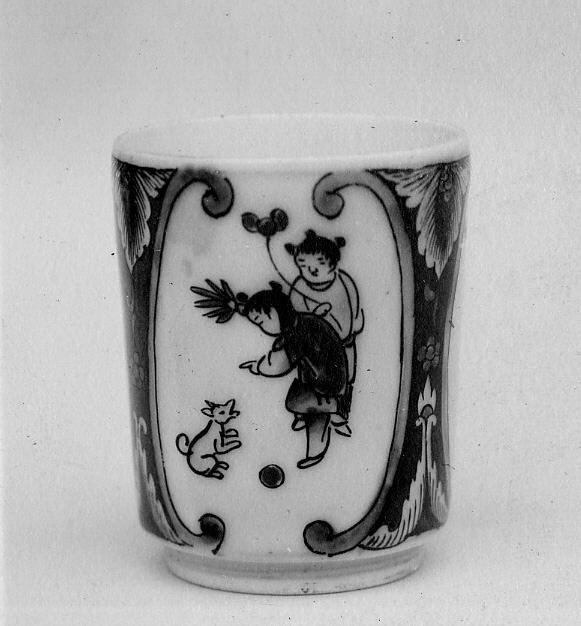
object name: cup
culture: japanese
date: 1780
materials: porcelain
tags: animals